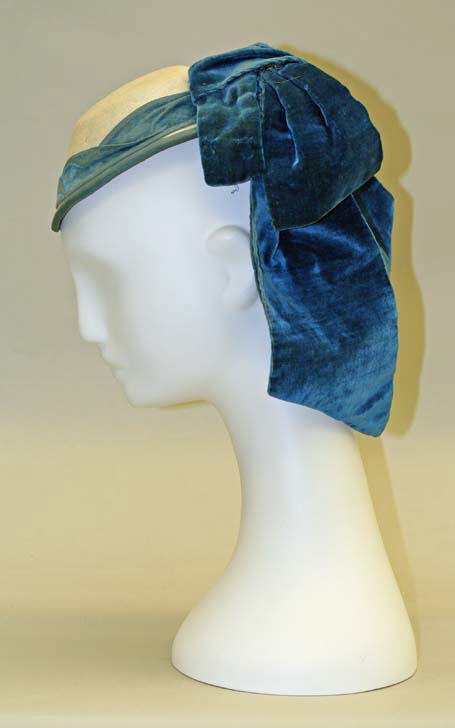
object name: promenade hat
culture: french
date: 1865-1870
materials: silk, wool